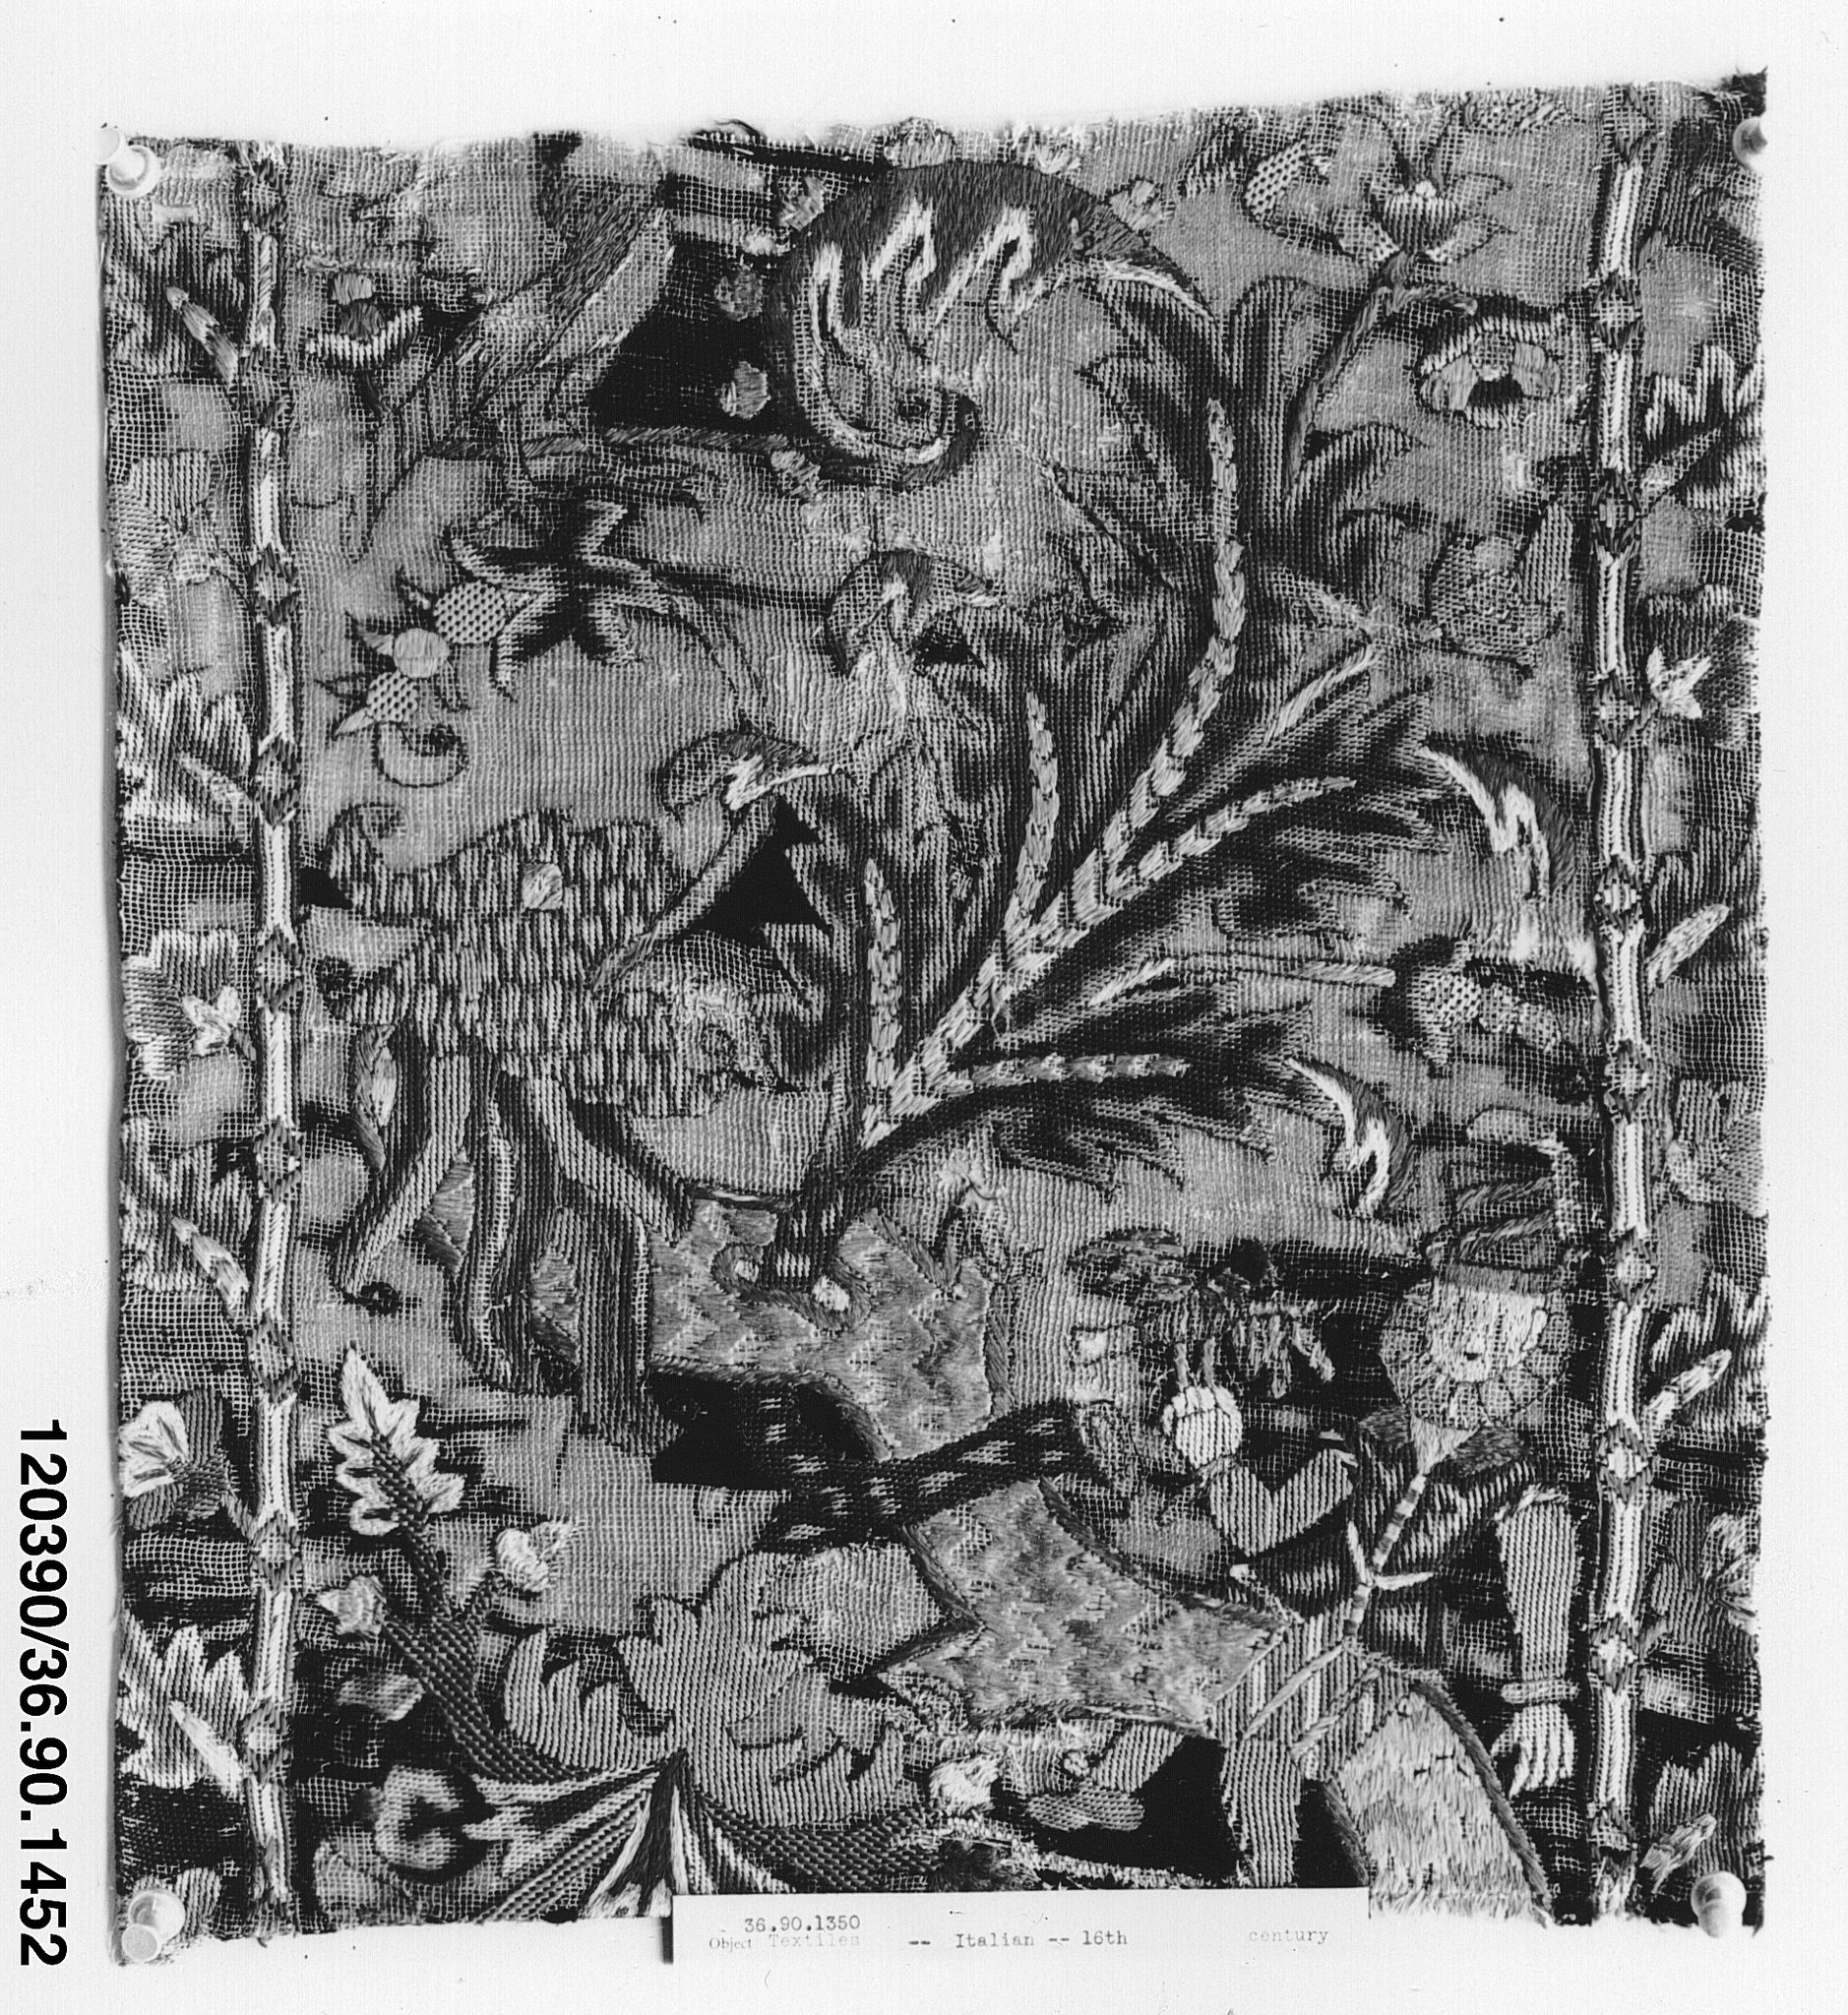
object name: piece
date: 1501-1600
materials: silk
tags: flowers